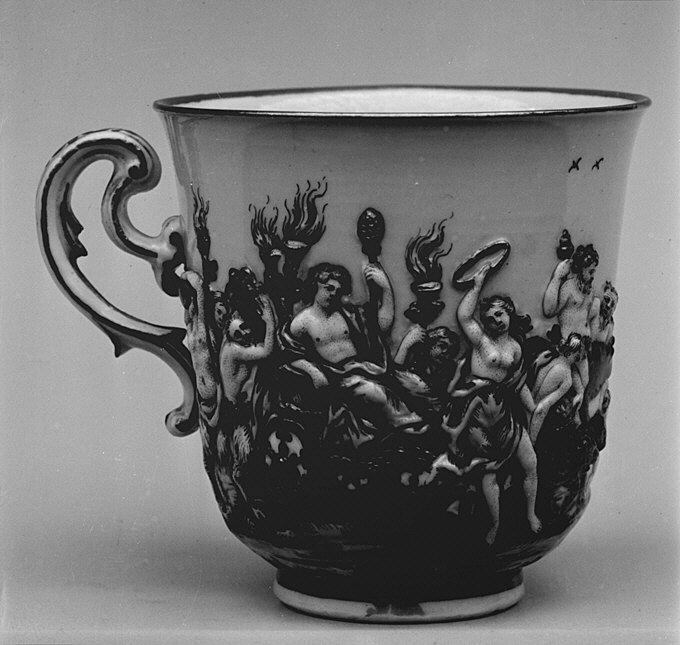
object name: coffee cup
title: Coffee cup (part of a service)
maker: doccia porcelain manufactory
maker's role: manufactory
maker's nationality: italian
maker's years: 1737-1896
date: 1760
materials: hard paste porcelain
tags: male nudes,female nudes